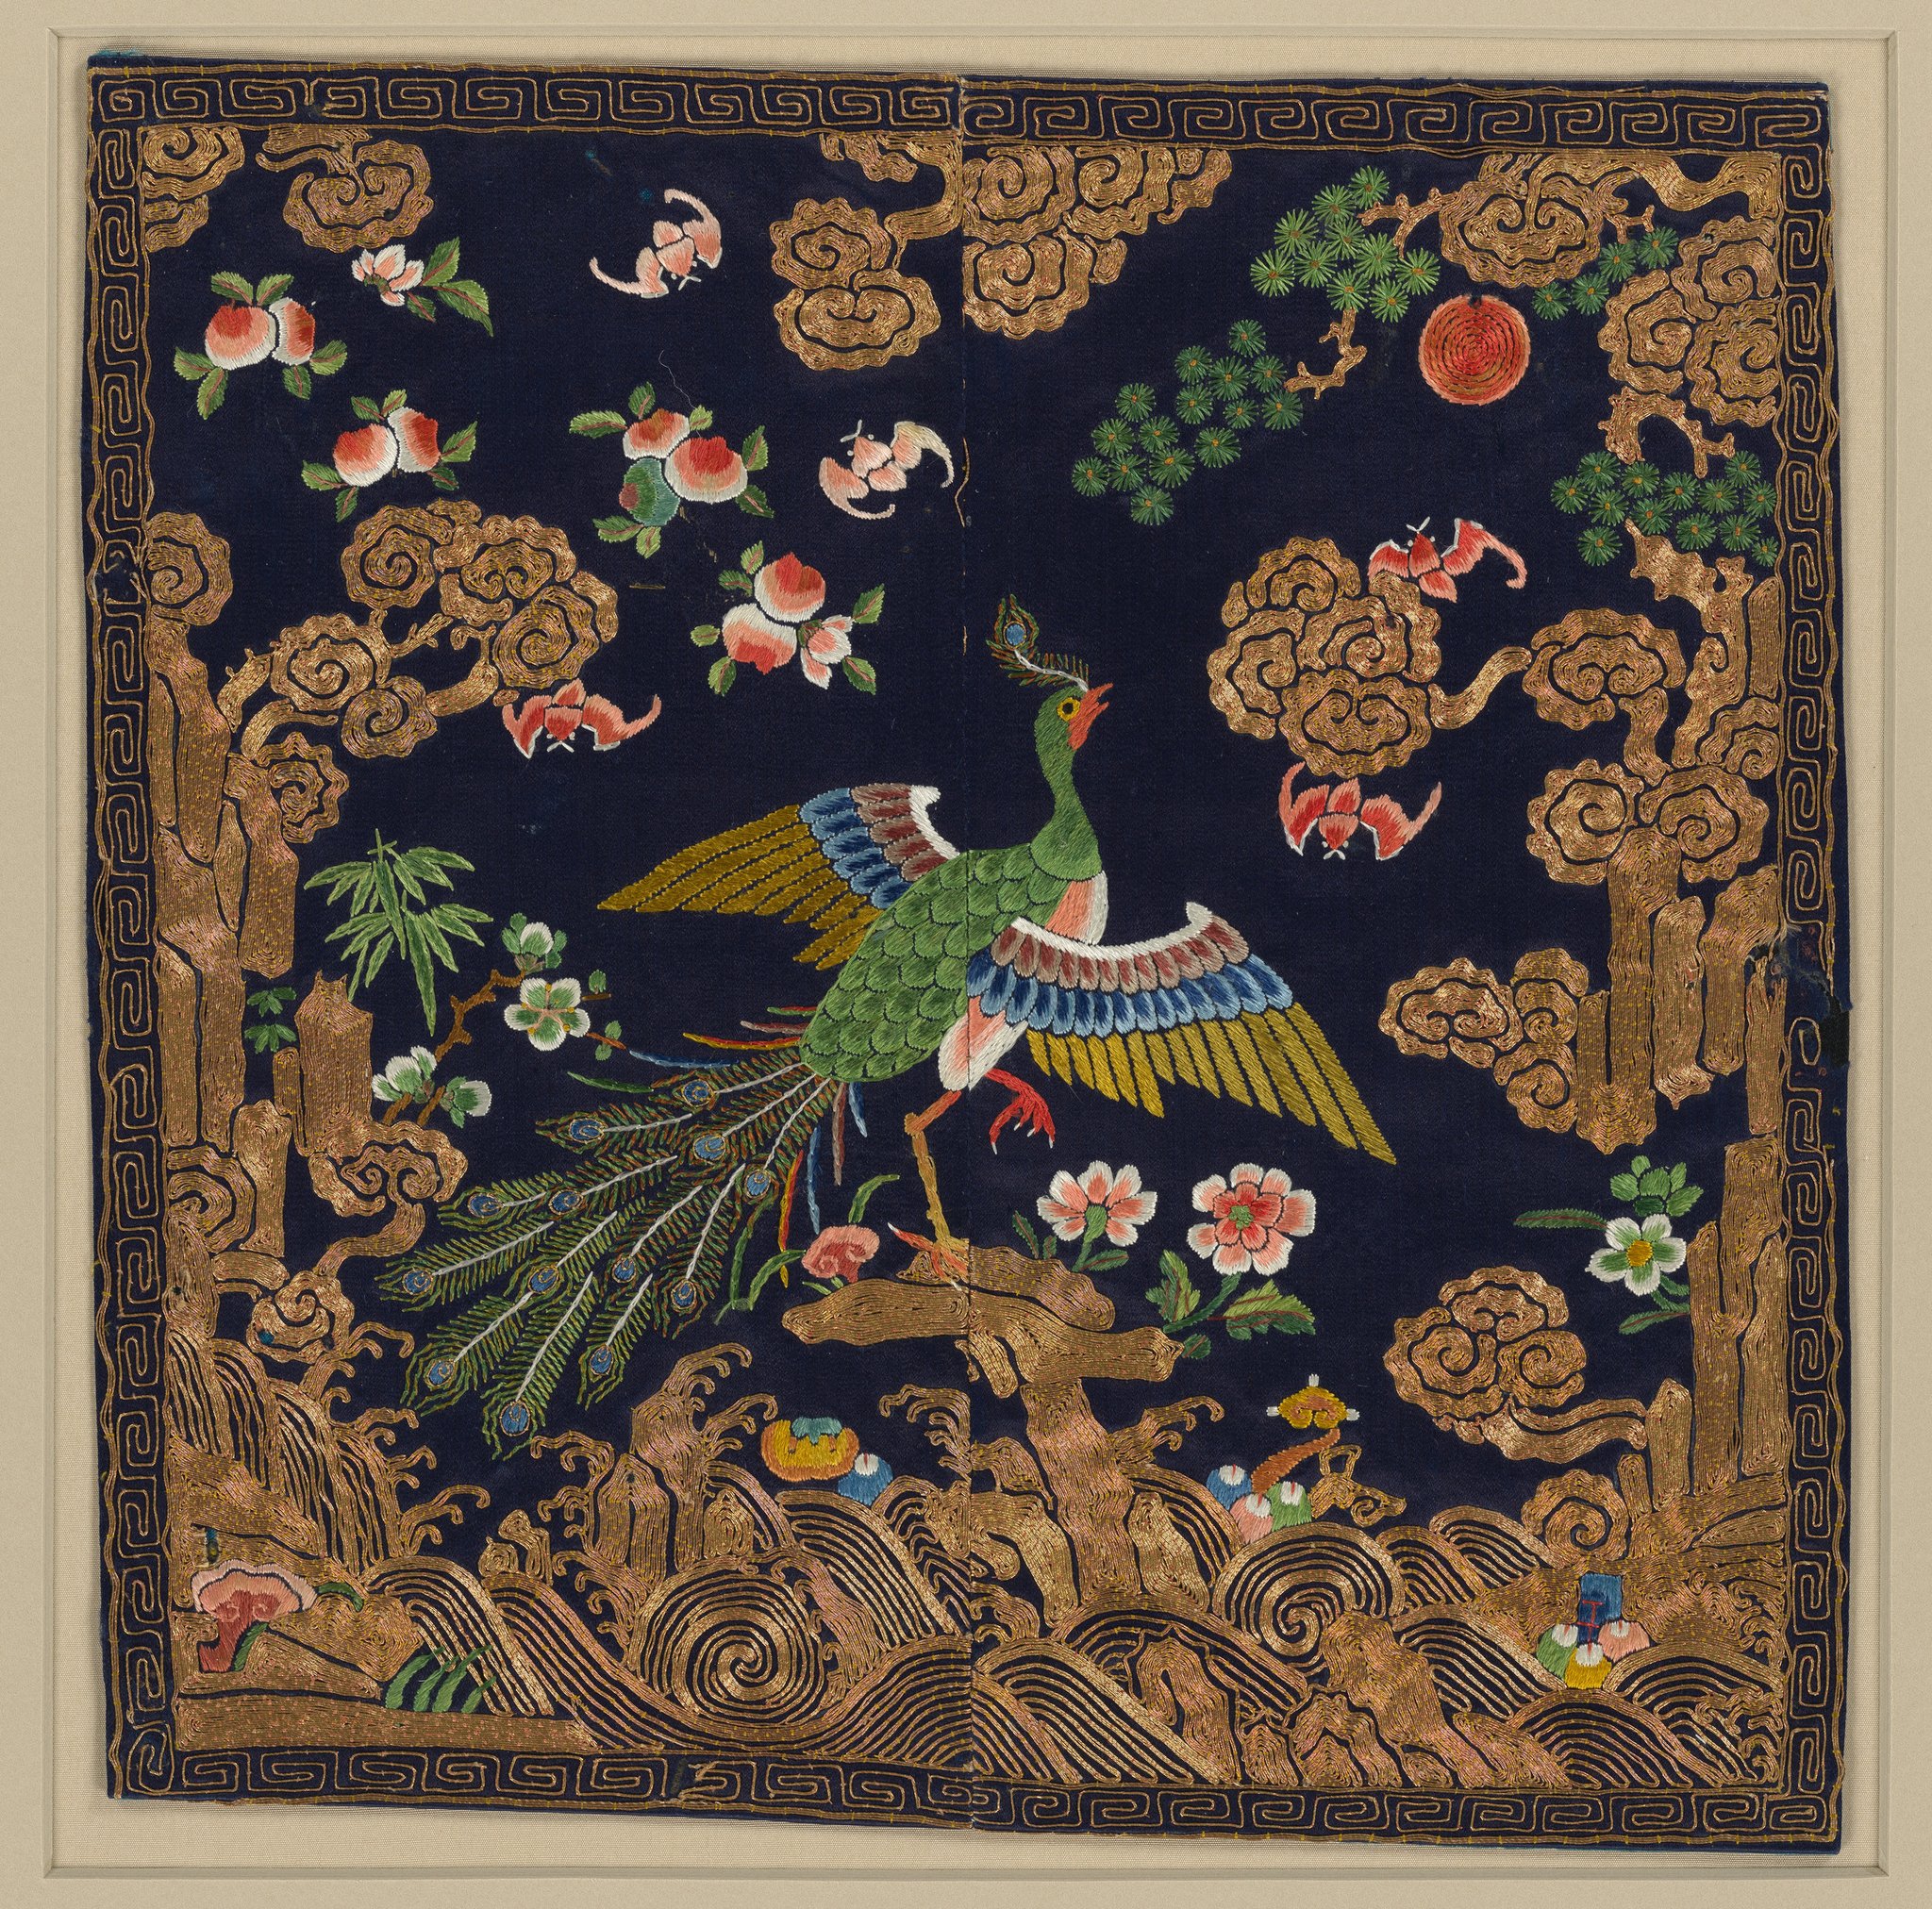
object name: rank badge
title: Rank badge with peacock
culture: chinese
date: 1701-1800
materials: metal thread, silk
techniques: embroidery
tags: bats,peacocks